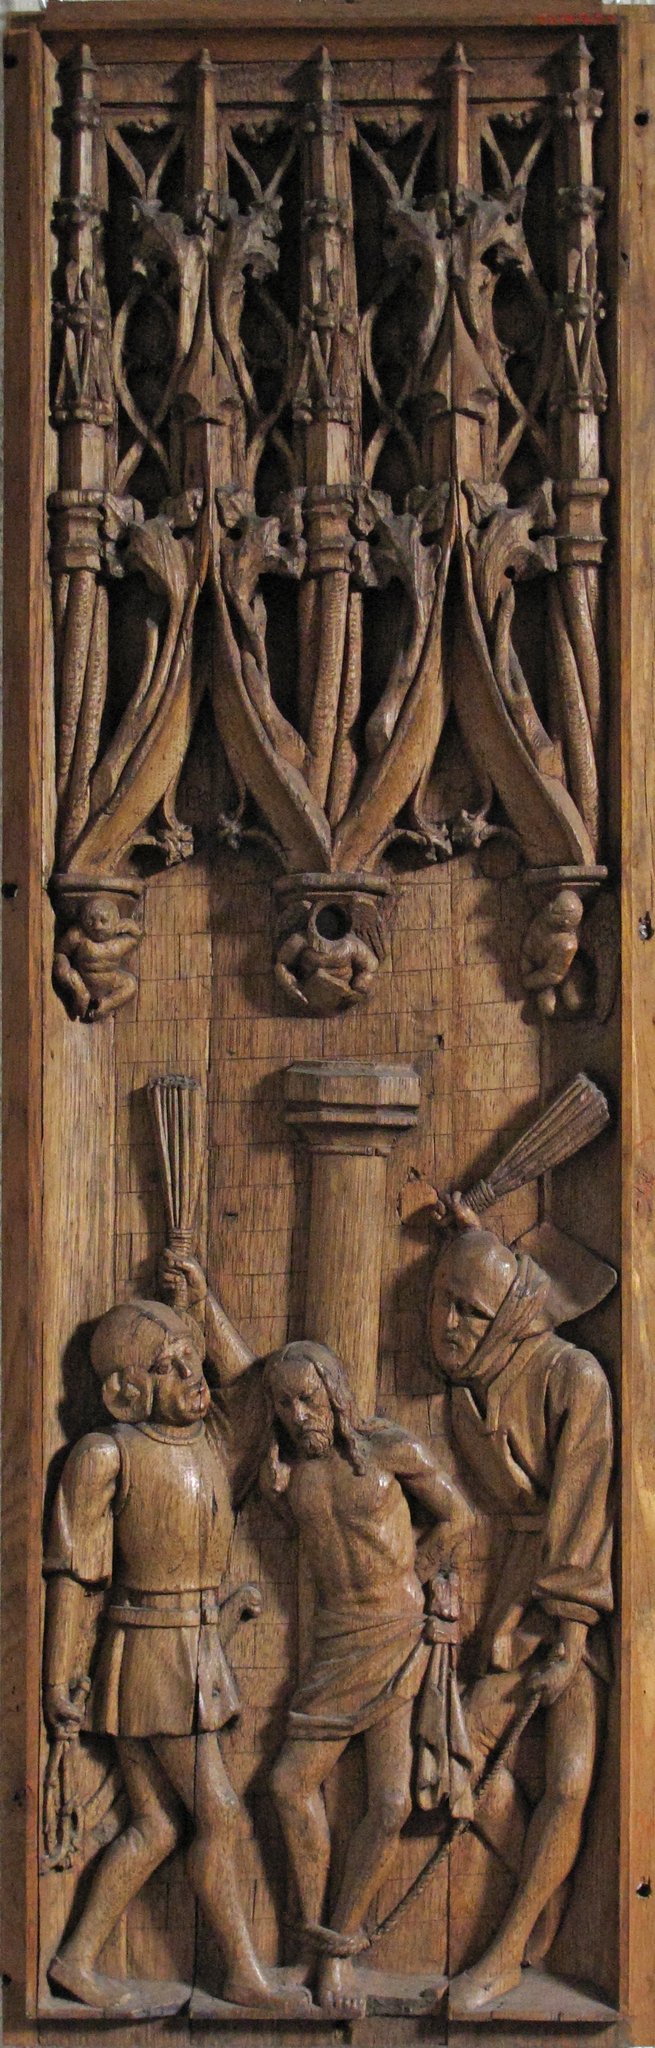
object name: panel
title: Panel with the Flagellation of Christ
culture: french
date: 1500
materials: wood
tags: men,christ